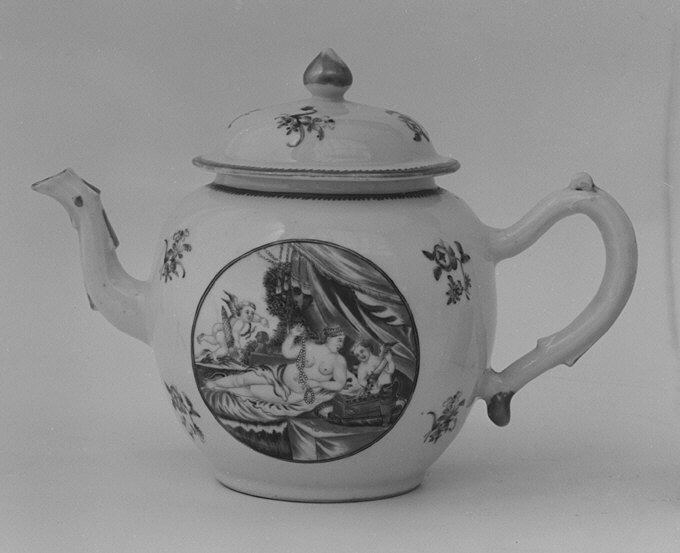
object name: teapot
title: Teapot (part of a service)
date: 1750-1770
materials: hard paste porcelain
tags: female nudes,cupid